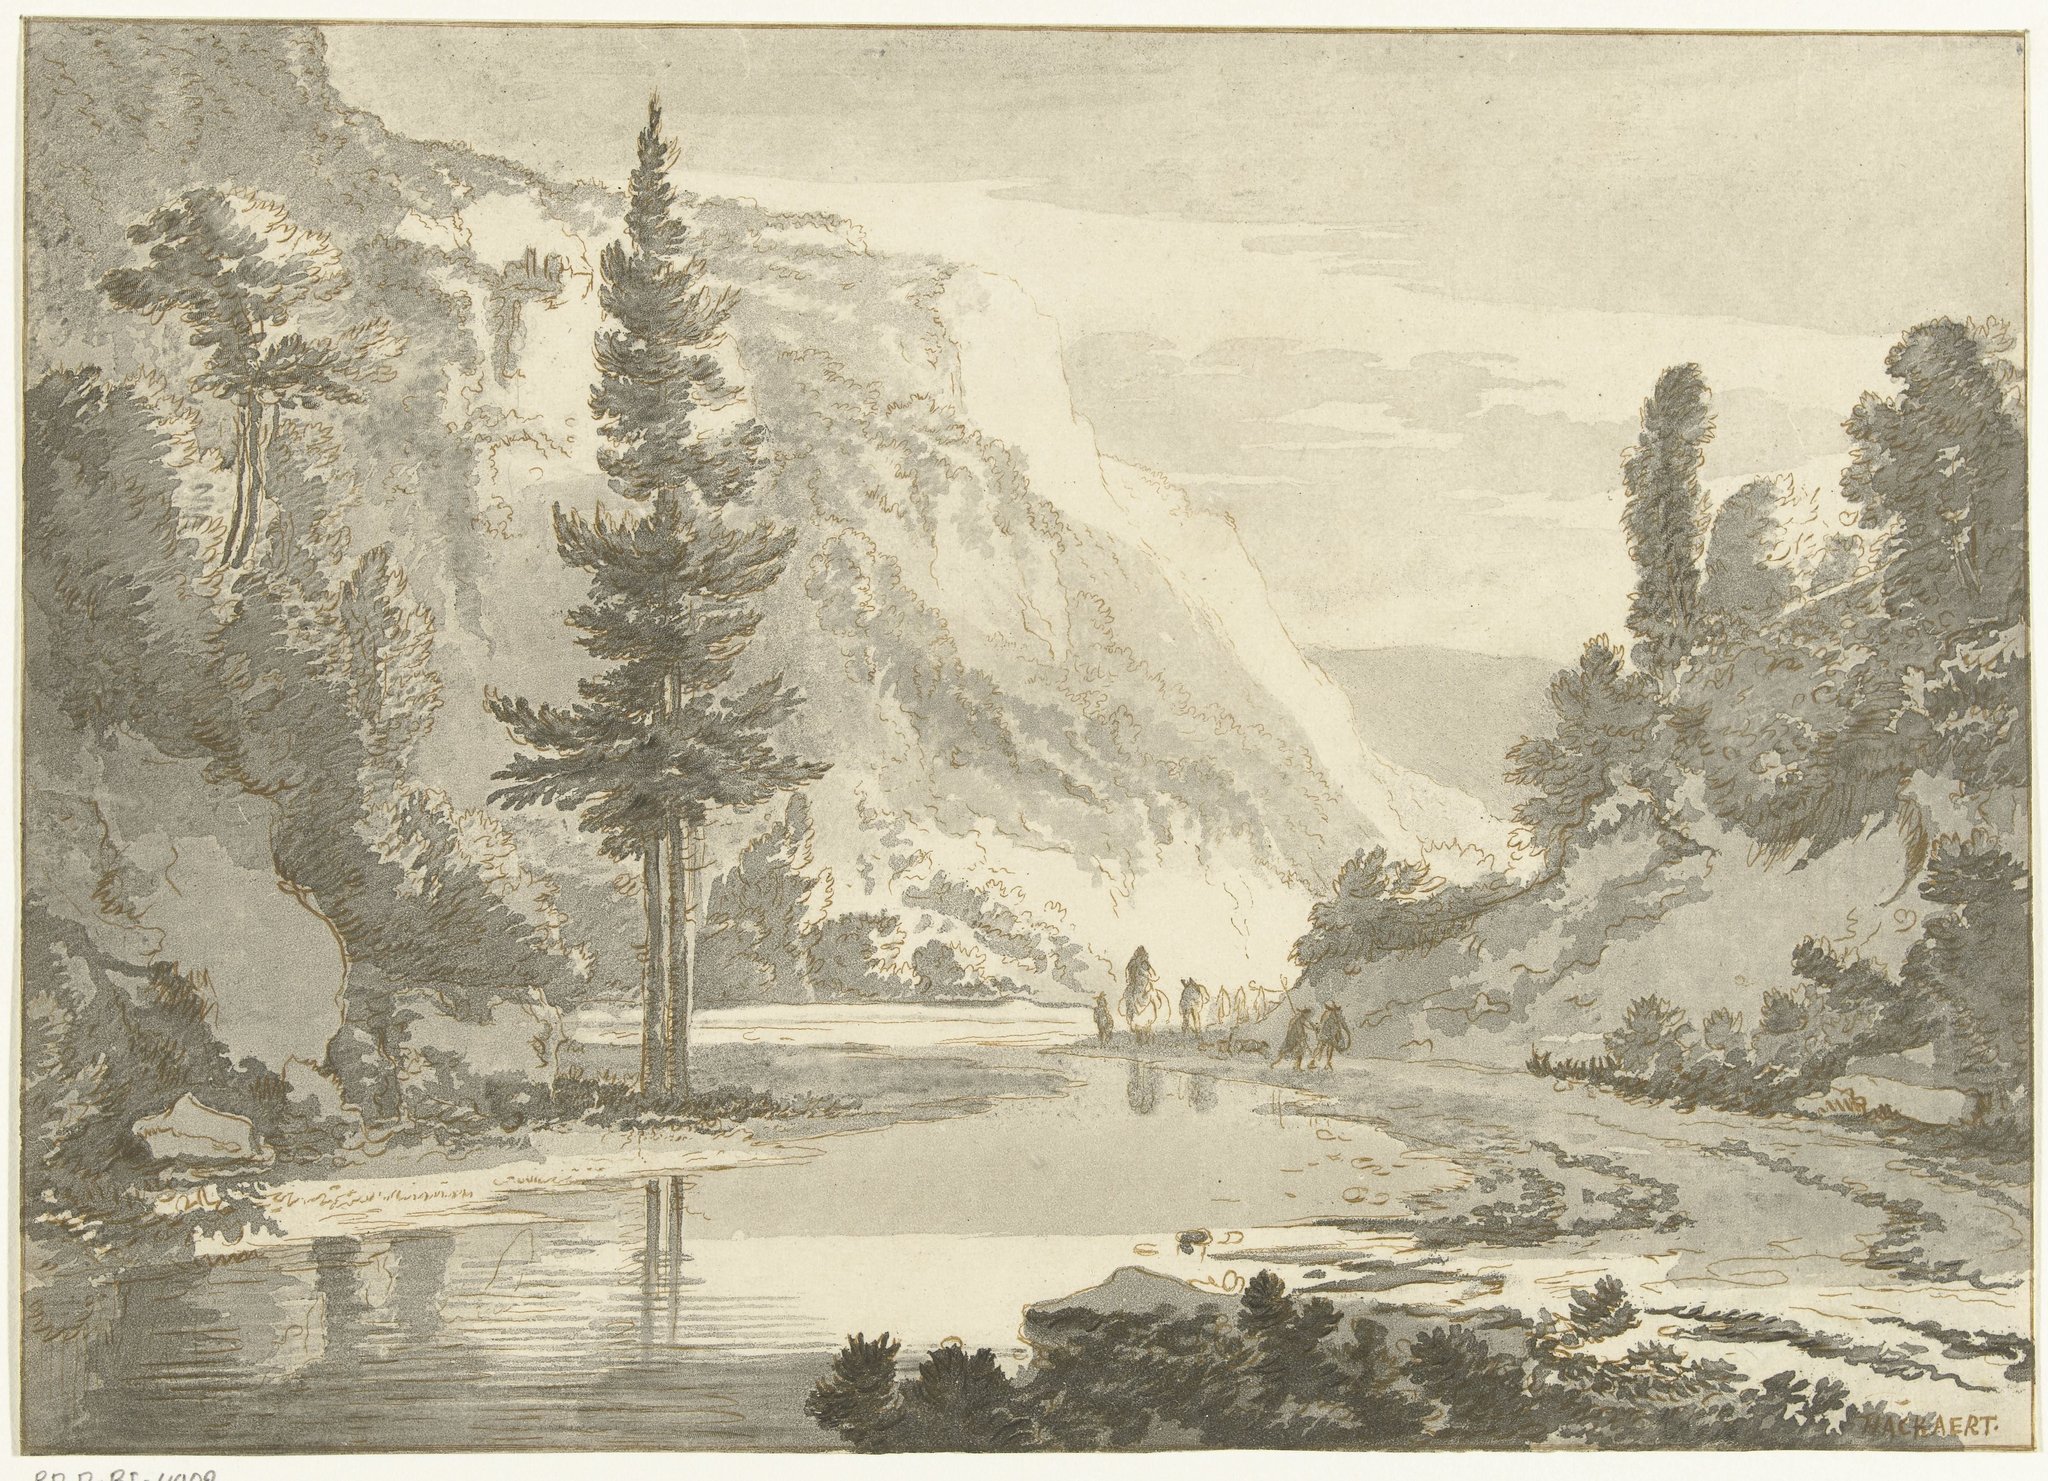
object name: print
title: Berglandschap met herders op een rivieroever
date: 1741-1803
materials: paper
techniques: aquatint, etching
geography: netherlands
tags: river, mountains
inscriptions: collector's mark: Lugt 12, collector's mark: Lugt 2527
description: Prent naar tekening van Jan Hackaert gedrukt met twee platen. Prent uit serie van negen prenttekeningen met acht landschappen en een zeegezicht naar Hollandse meesters uit de 17e eeuw, zie Huffel 1921, p. 33-35. Deze serie werd door Christiaan Josi opgenomen in een uitgave met 100 werken naar Hollandse en Vlaamse meesters: Collection d'imitations de dessins d'après les principaux maîtres hollandais et flamands, Londen, C.Josi, 1821. Alle prenten in deze uitgave dragen op het verso het wapen van Cornelis Ploos van Amstel, de initiatiefnemer voor de uitgave.